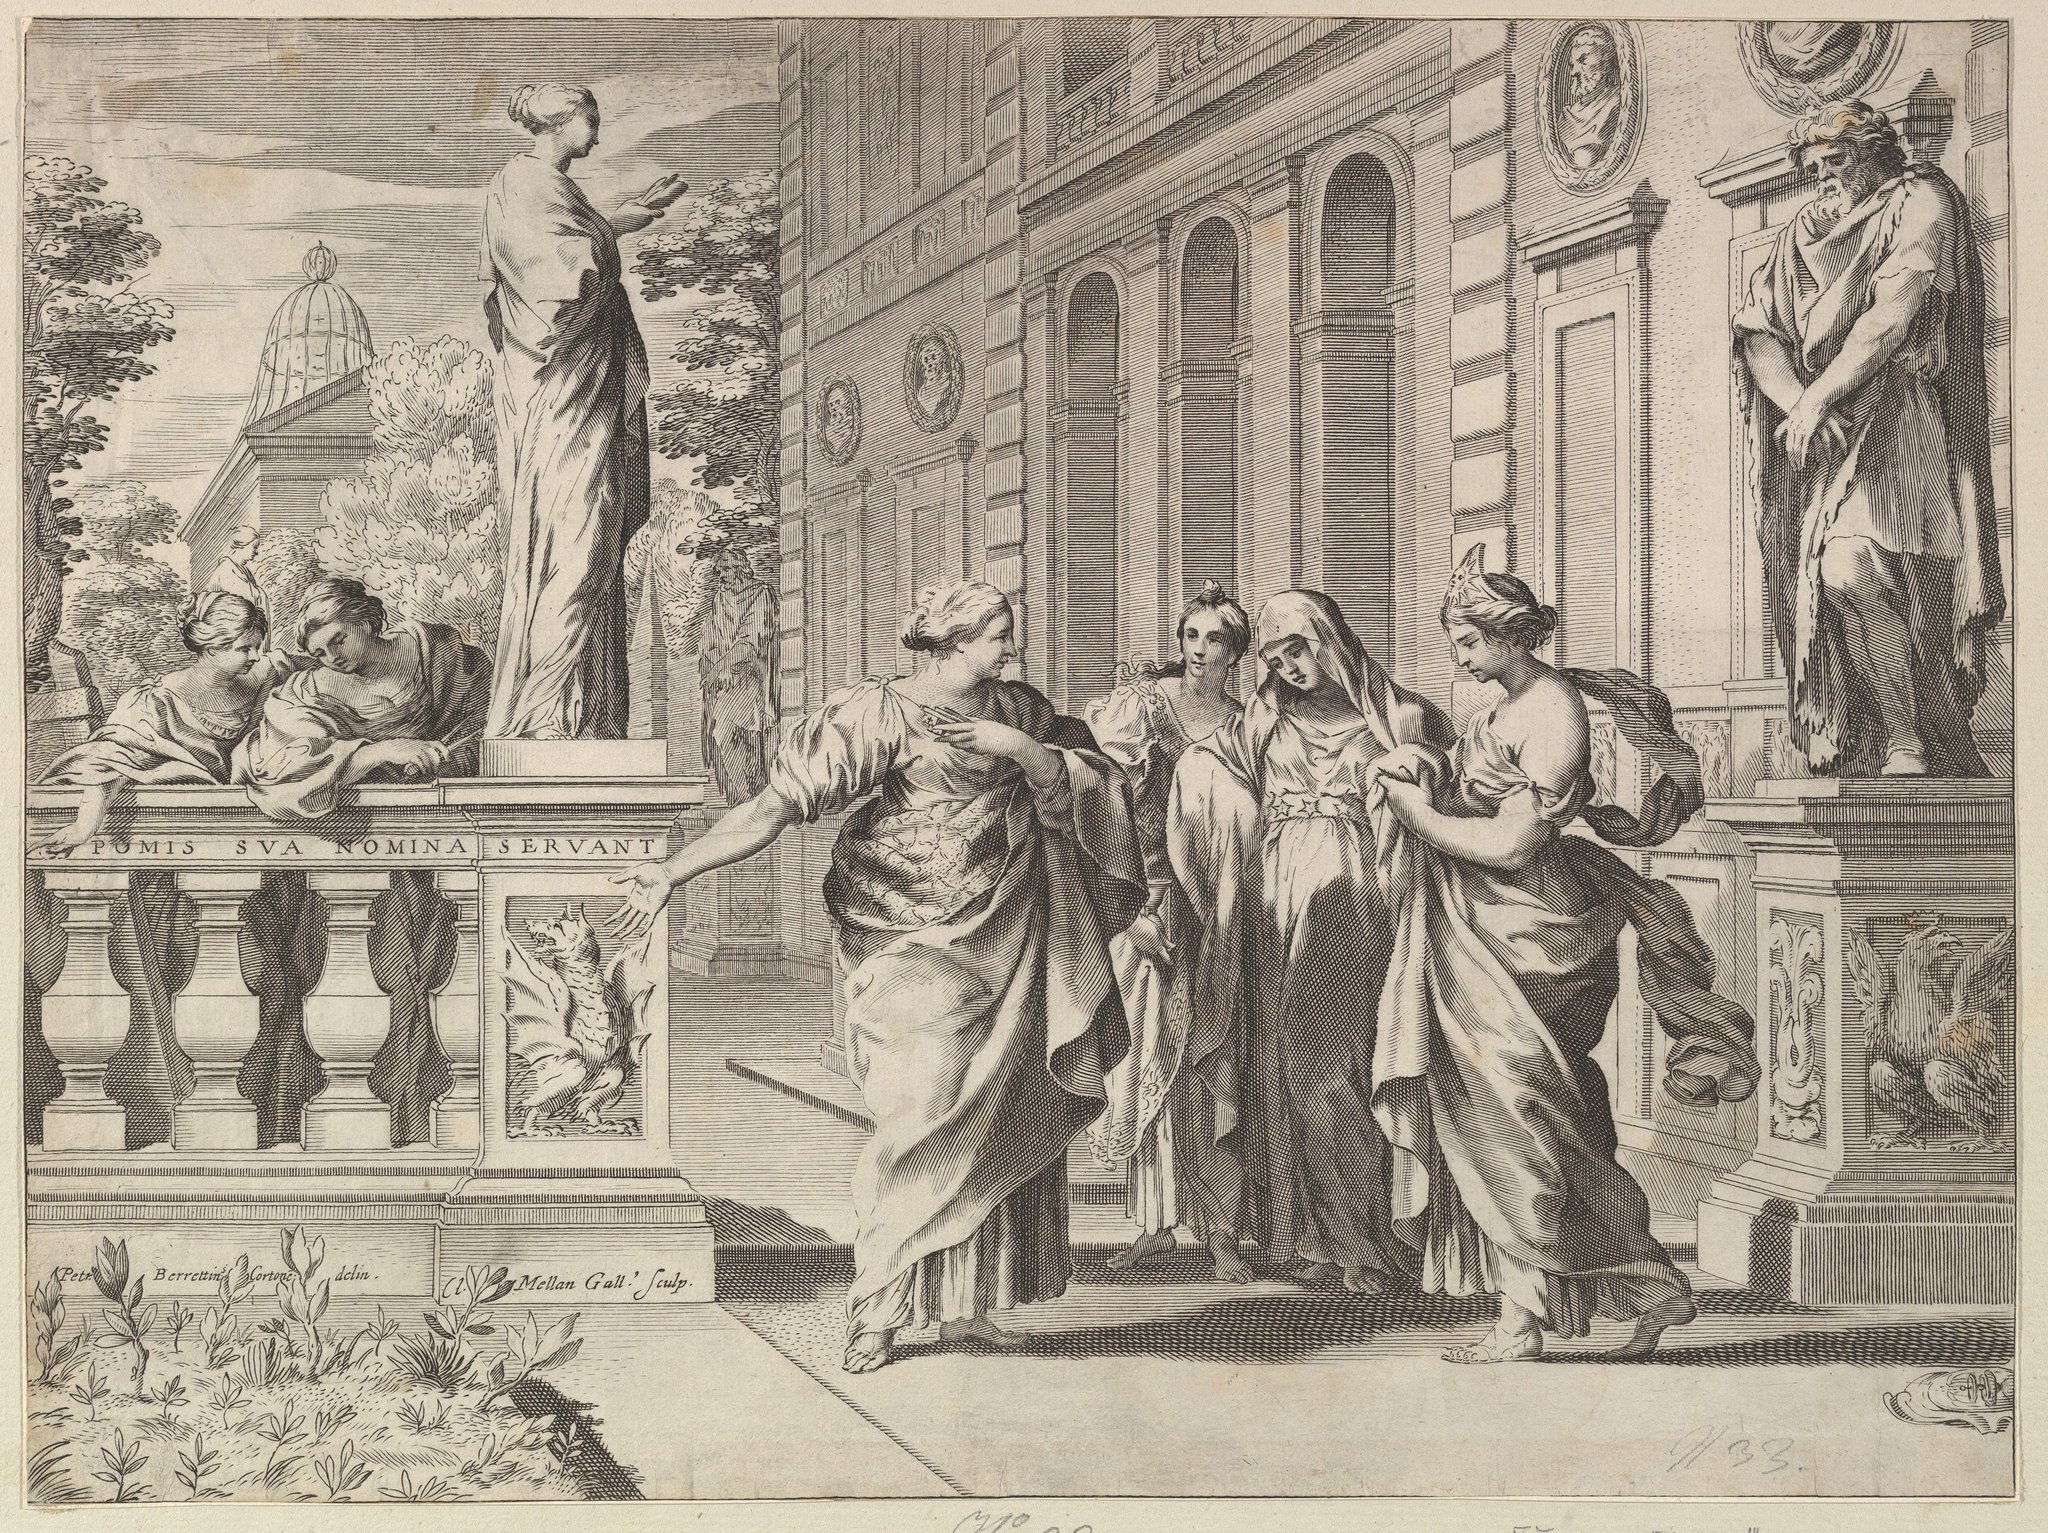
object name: print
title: Allegory in Honor of the Roman College Founded by the Borghese Family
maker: claude mellan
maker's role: artist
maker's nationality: french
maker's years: 1598-1688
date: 1615-1688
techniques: engraving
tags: sculpture,buildings,women